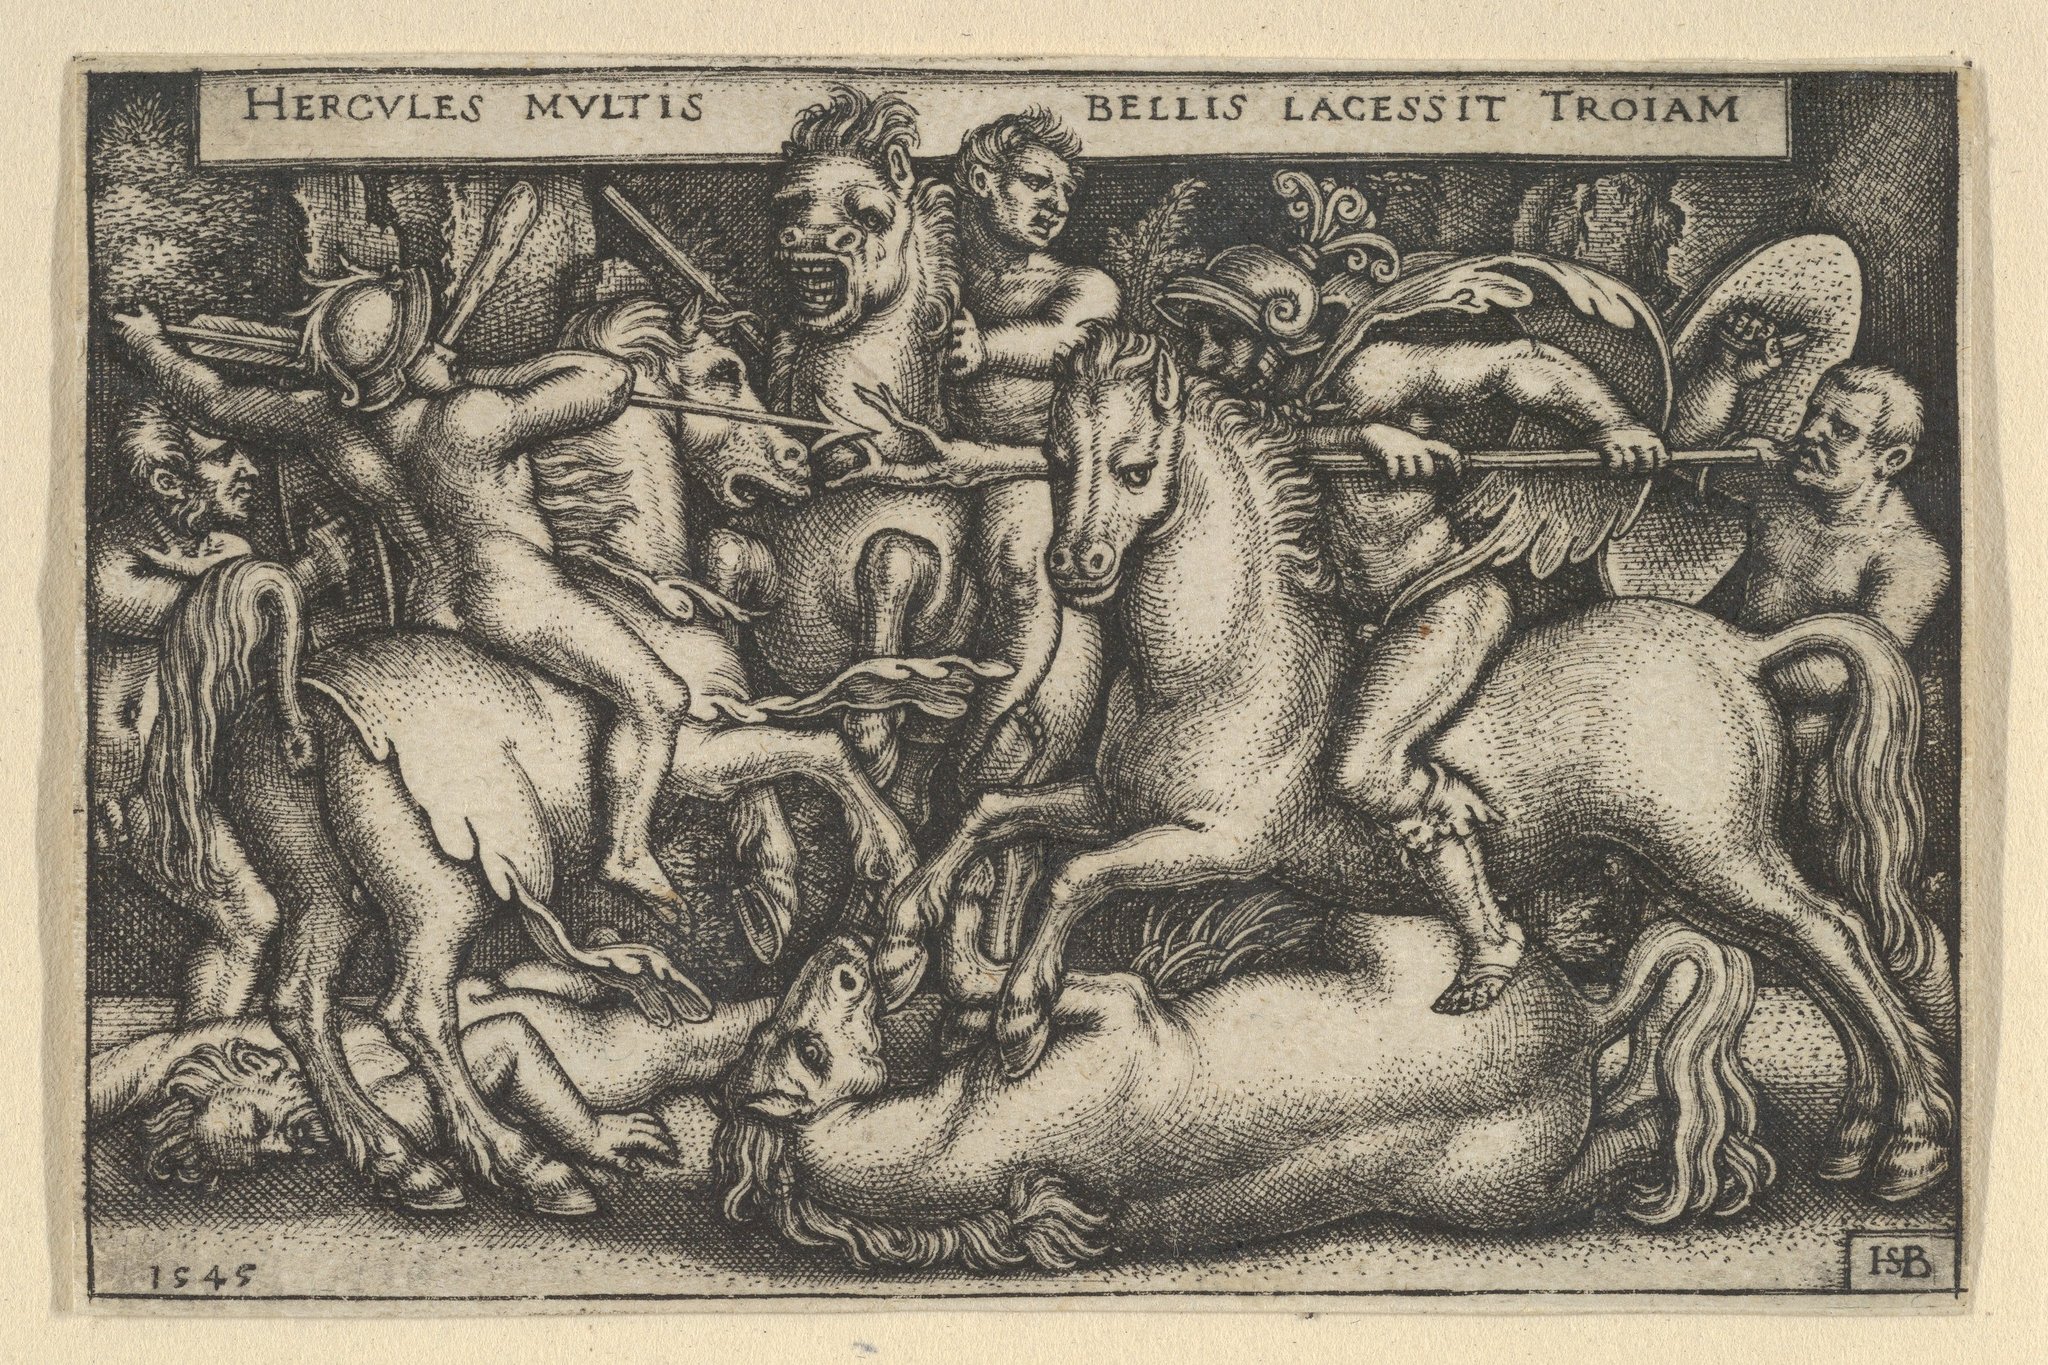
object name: print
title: Hercules Fighting Against the Trojans, from "The Labors of Hercules"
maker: sebald beham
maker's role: artist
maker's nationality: german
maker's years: 1500-1550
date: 1500-1550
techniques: engraving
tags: soldiers,hercules,horses